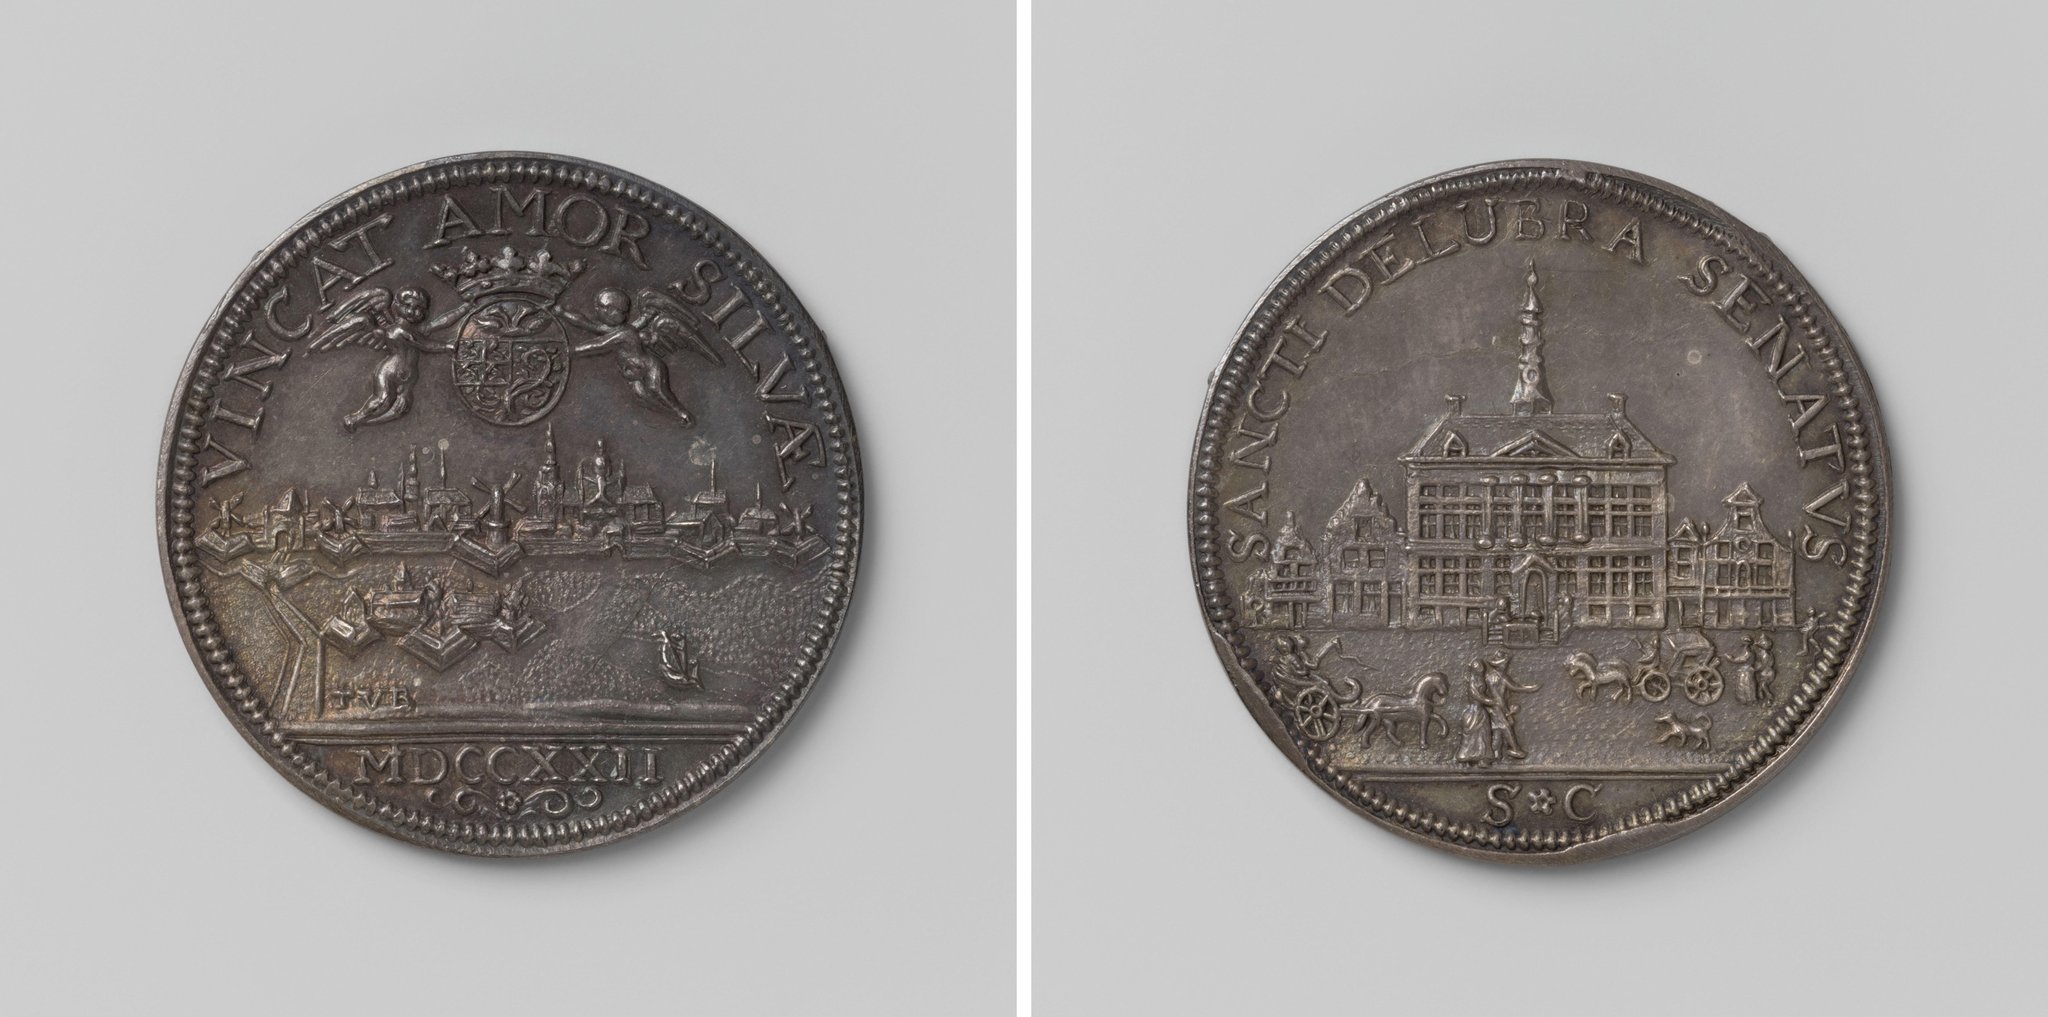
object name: council medal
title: Vroedschapspenning van de stad 's-Hertogenbosch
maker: theodorus casparus van berckel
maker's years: 1680-1734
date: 1722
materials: silver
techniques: striking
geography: den bosch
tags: den bosch